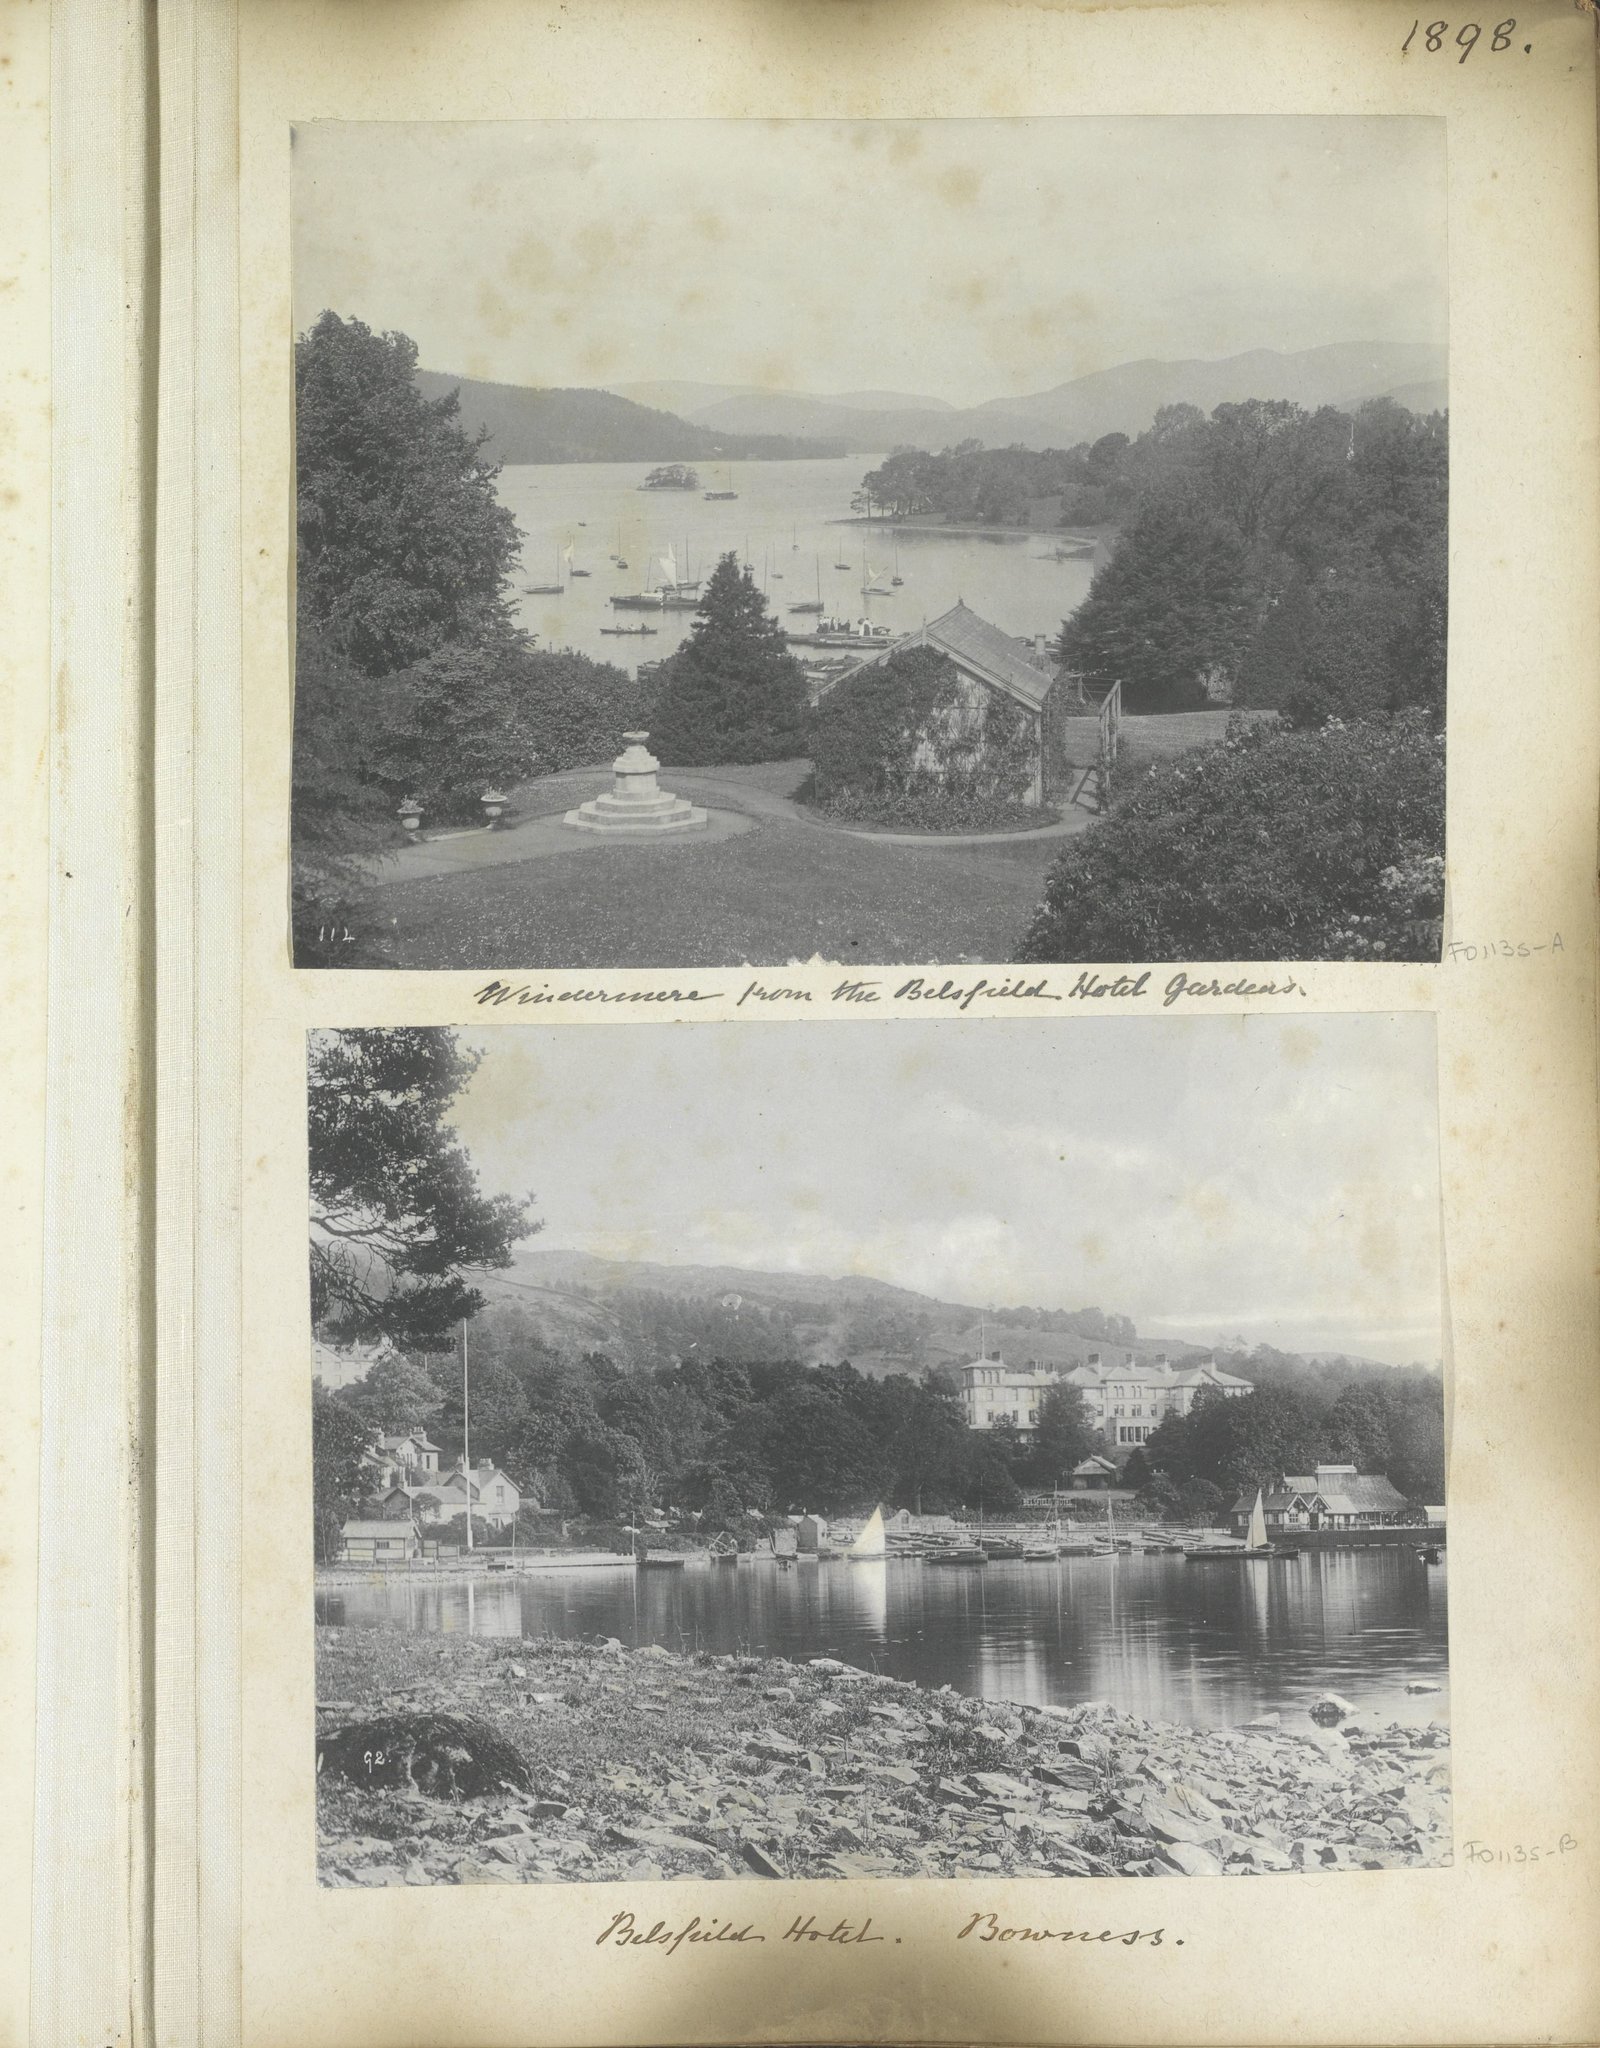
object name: photograph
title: Gezicht op Windermere vanaf de Belsfield Hotel Gardens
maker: Anonymous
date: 1898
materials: paper, photographic support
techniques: platinum process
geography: lake district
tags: lake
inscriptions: number: ‘112’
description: Onderdeel van Reisalbum met foto's van bezienswaardigheden in Engeland en Frankrijk.